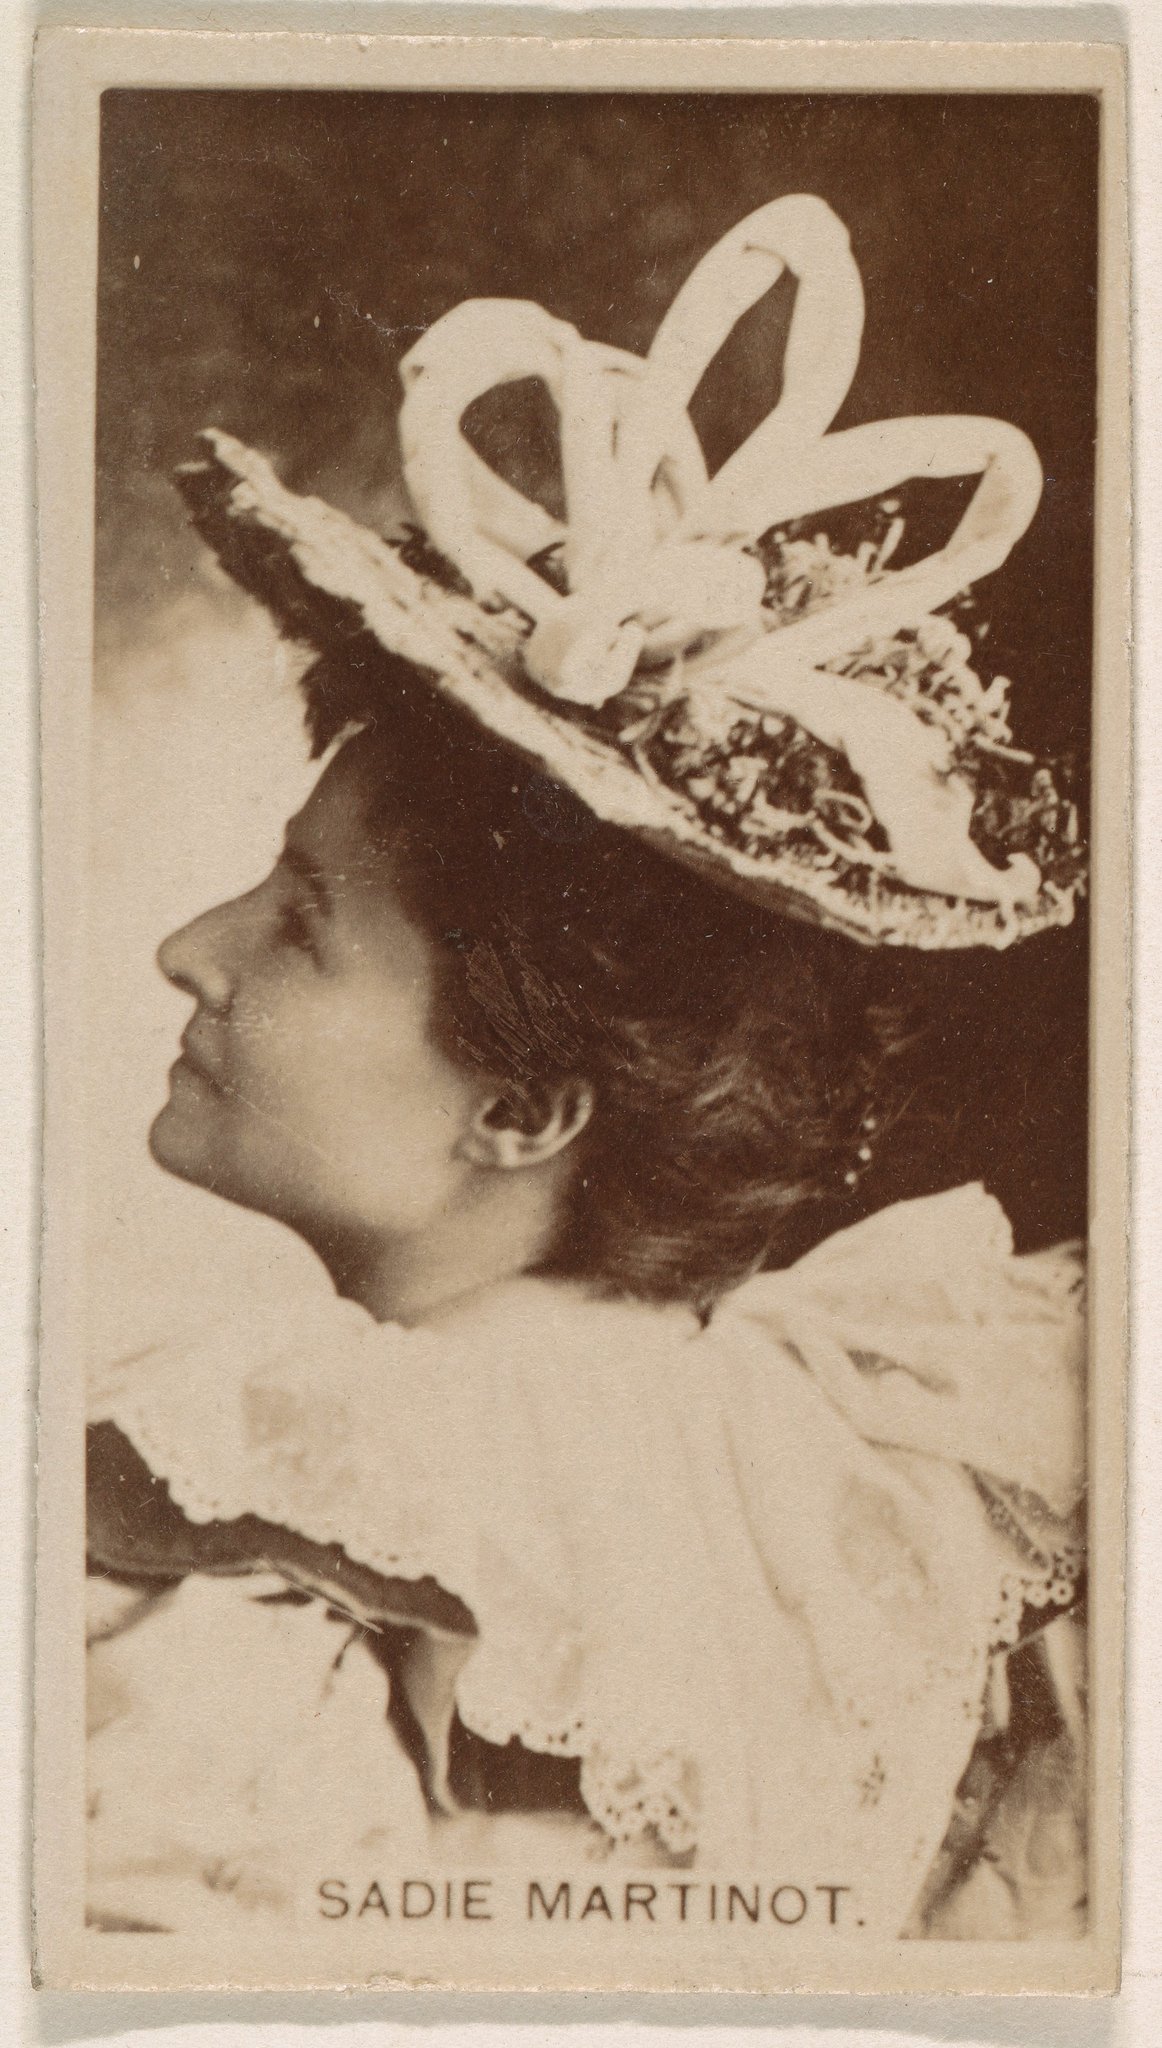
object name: photograph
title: Sadie Martinot, from the Actresses series (N245) issued by Kinney Brothers to promote Sweet Caporal Cigarettes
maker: kinney brothers tobacco company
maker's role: publisher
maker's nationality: american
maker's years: 1869-2011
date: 1890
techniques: albumen silver print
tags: women,actresses